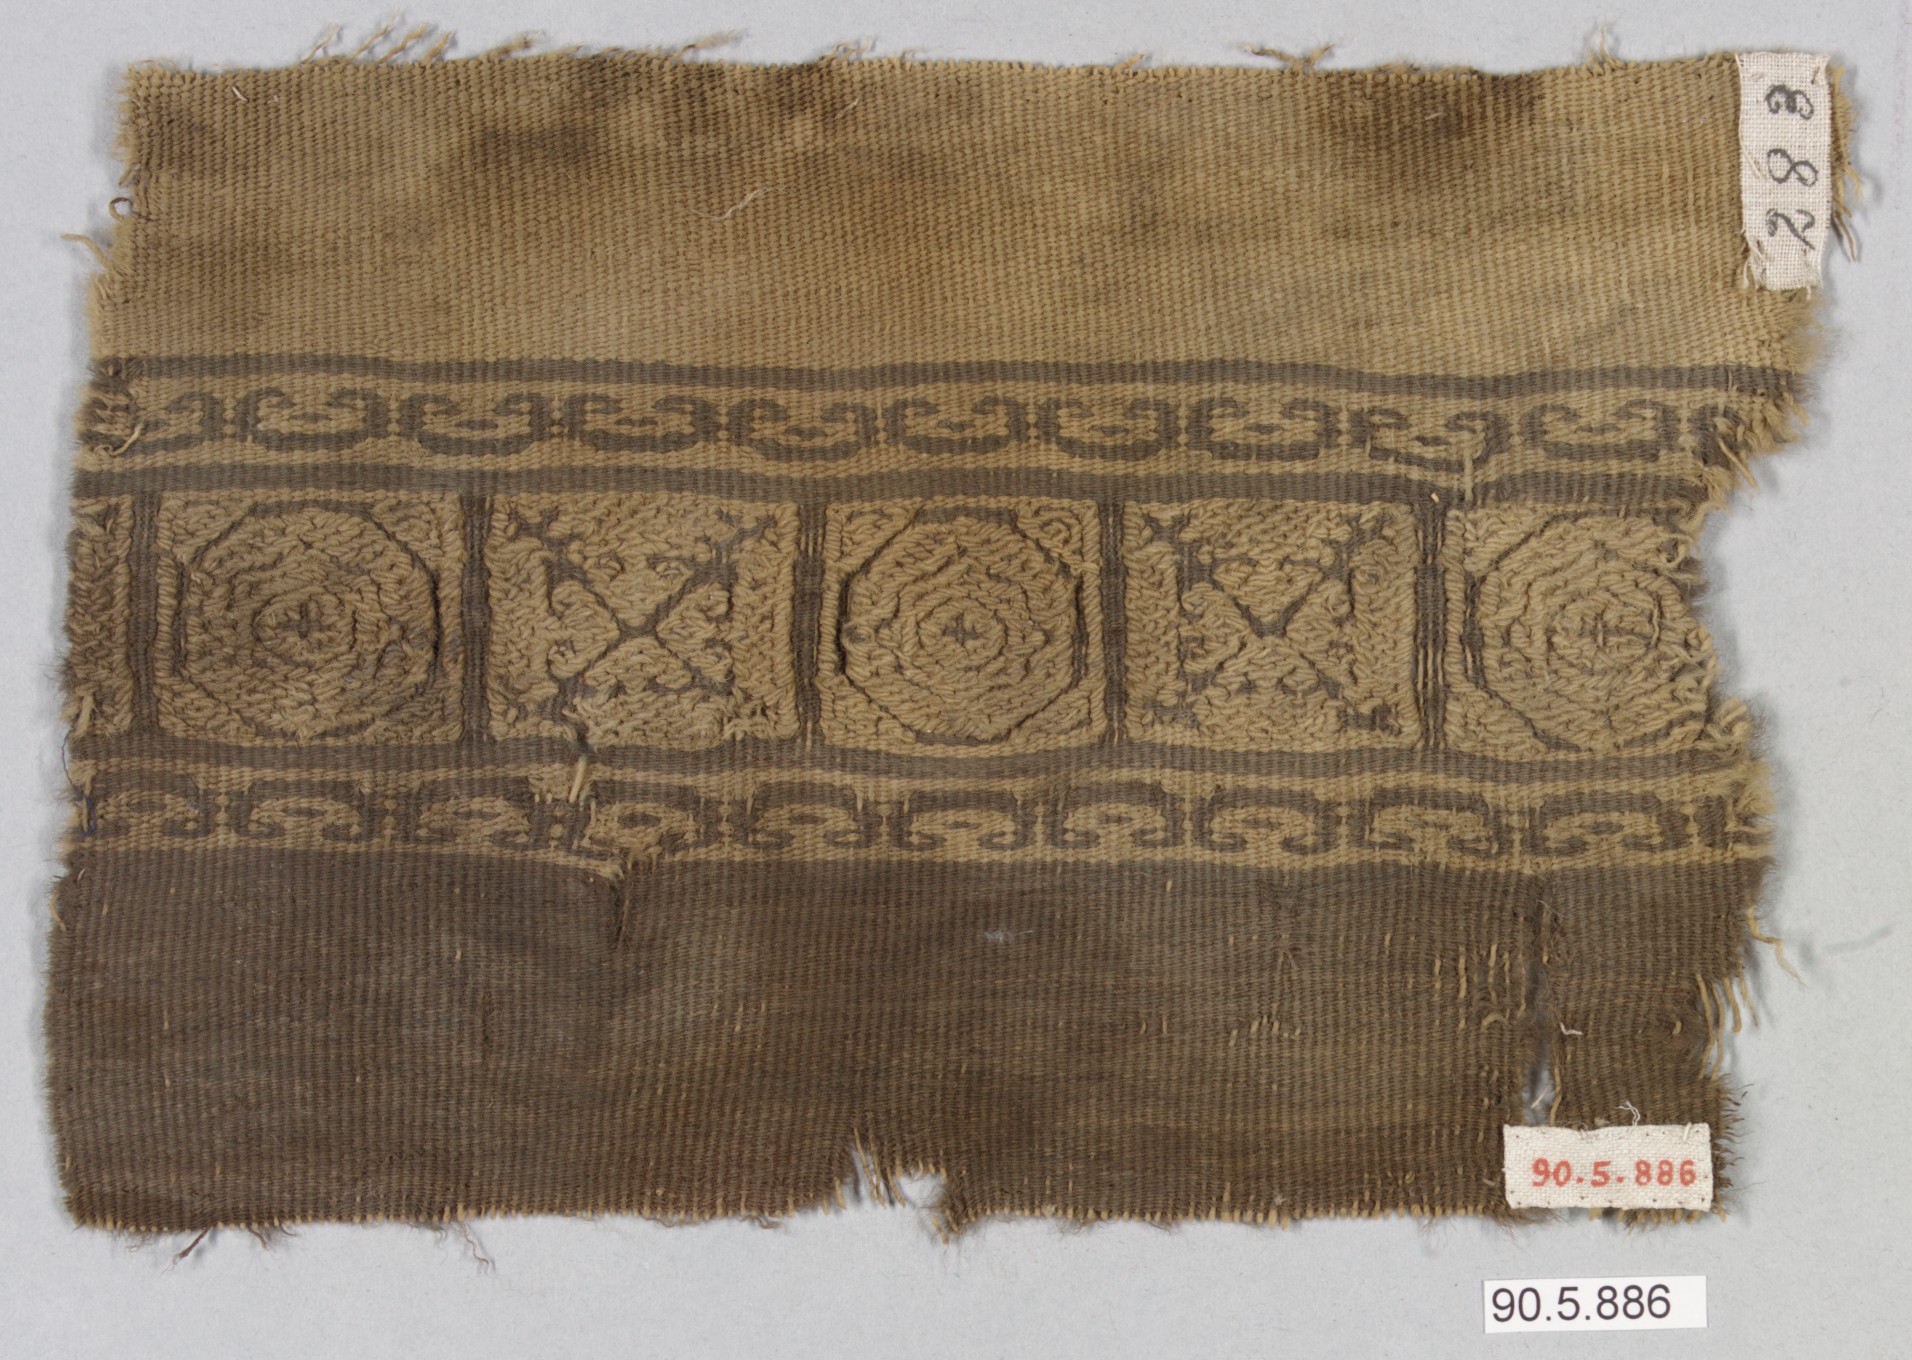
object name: textile fragment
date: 401-600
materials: wool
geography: egypt